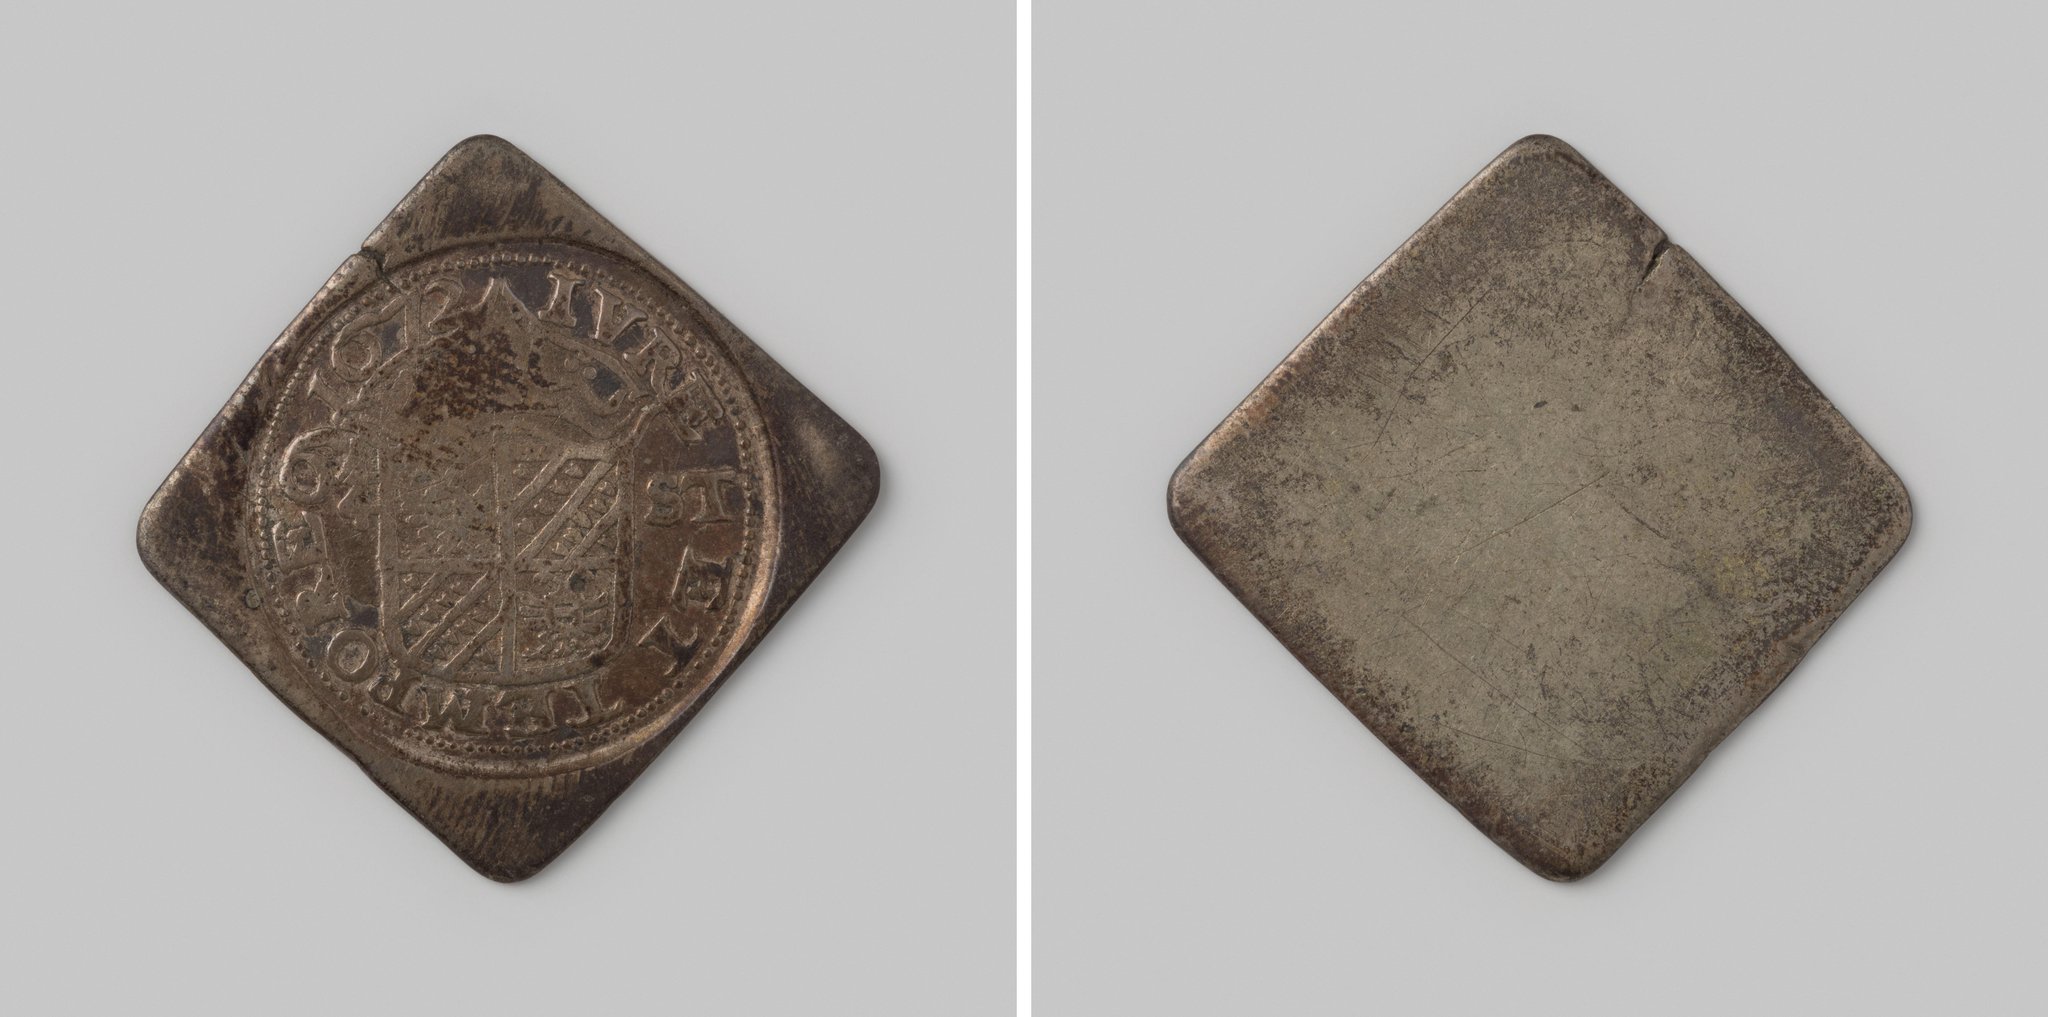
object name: coin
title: Herdenkingsmunt van 6 1/4 stuiver van de stad Groningen, 1672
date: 1672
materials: silver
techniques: striking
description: Zilveren vierkante herdenkingsmunt. Voorzijde: tussen waarde-aanduiding: 6 1/4 ST gekroond samengesteld wapenschild van de stad en de Ommelanden. Jaartal in omschrift linksboven. Keerzijde: glad.